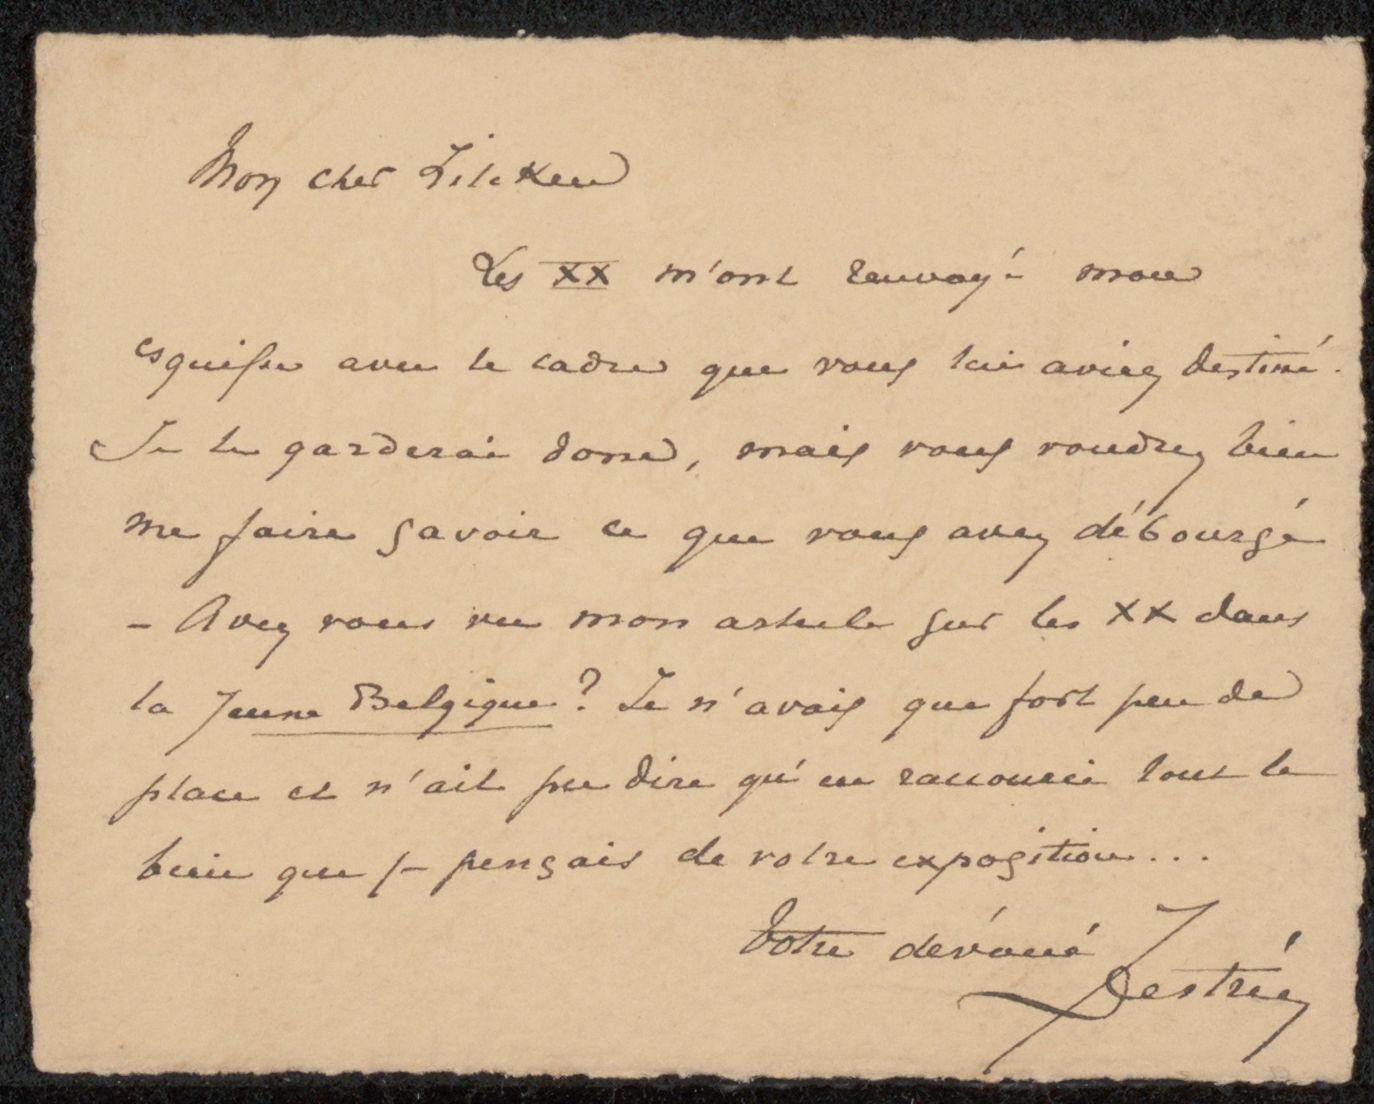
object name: letter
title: Brief aan Philip Zilcken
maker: jules destrée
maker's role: politician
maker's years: 1863-1936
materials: cardboard, ink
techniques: pen, writing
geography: charleroi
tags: the hague, painter, draughtsman, philip zilcken, exhibition ~ art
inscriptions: collector's mark: ‘RPK’